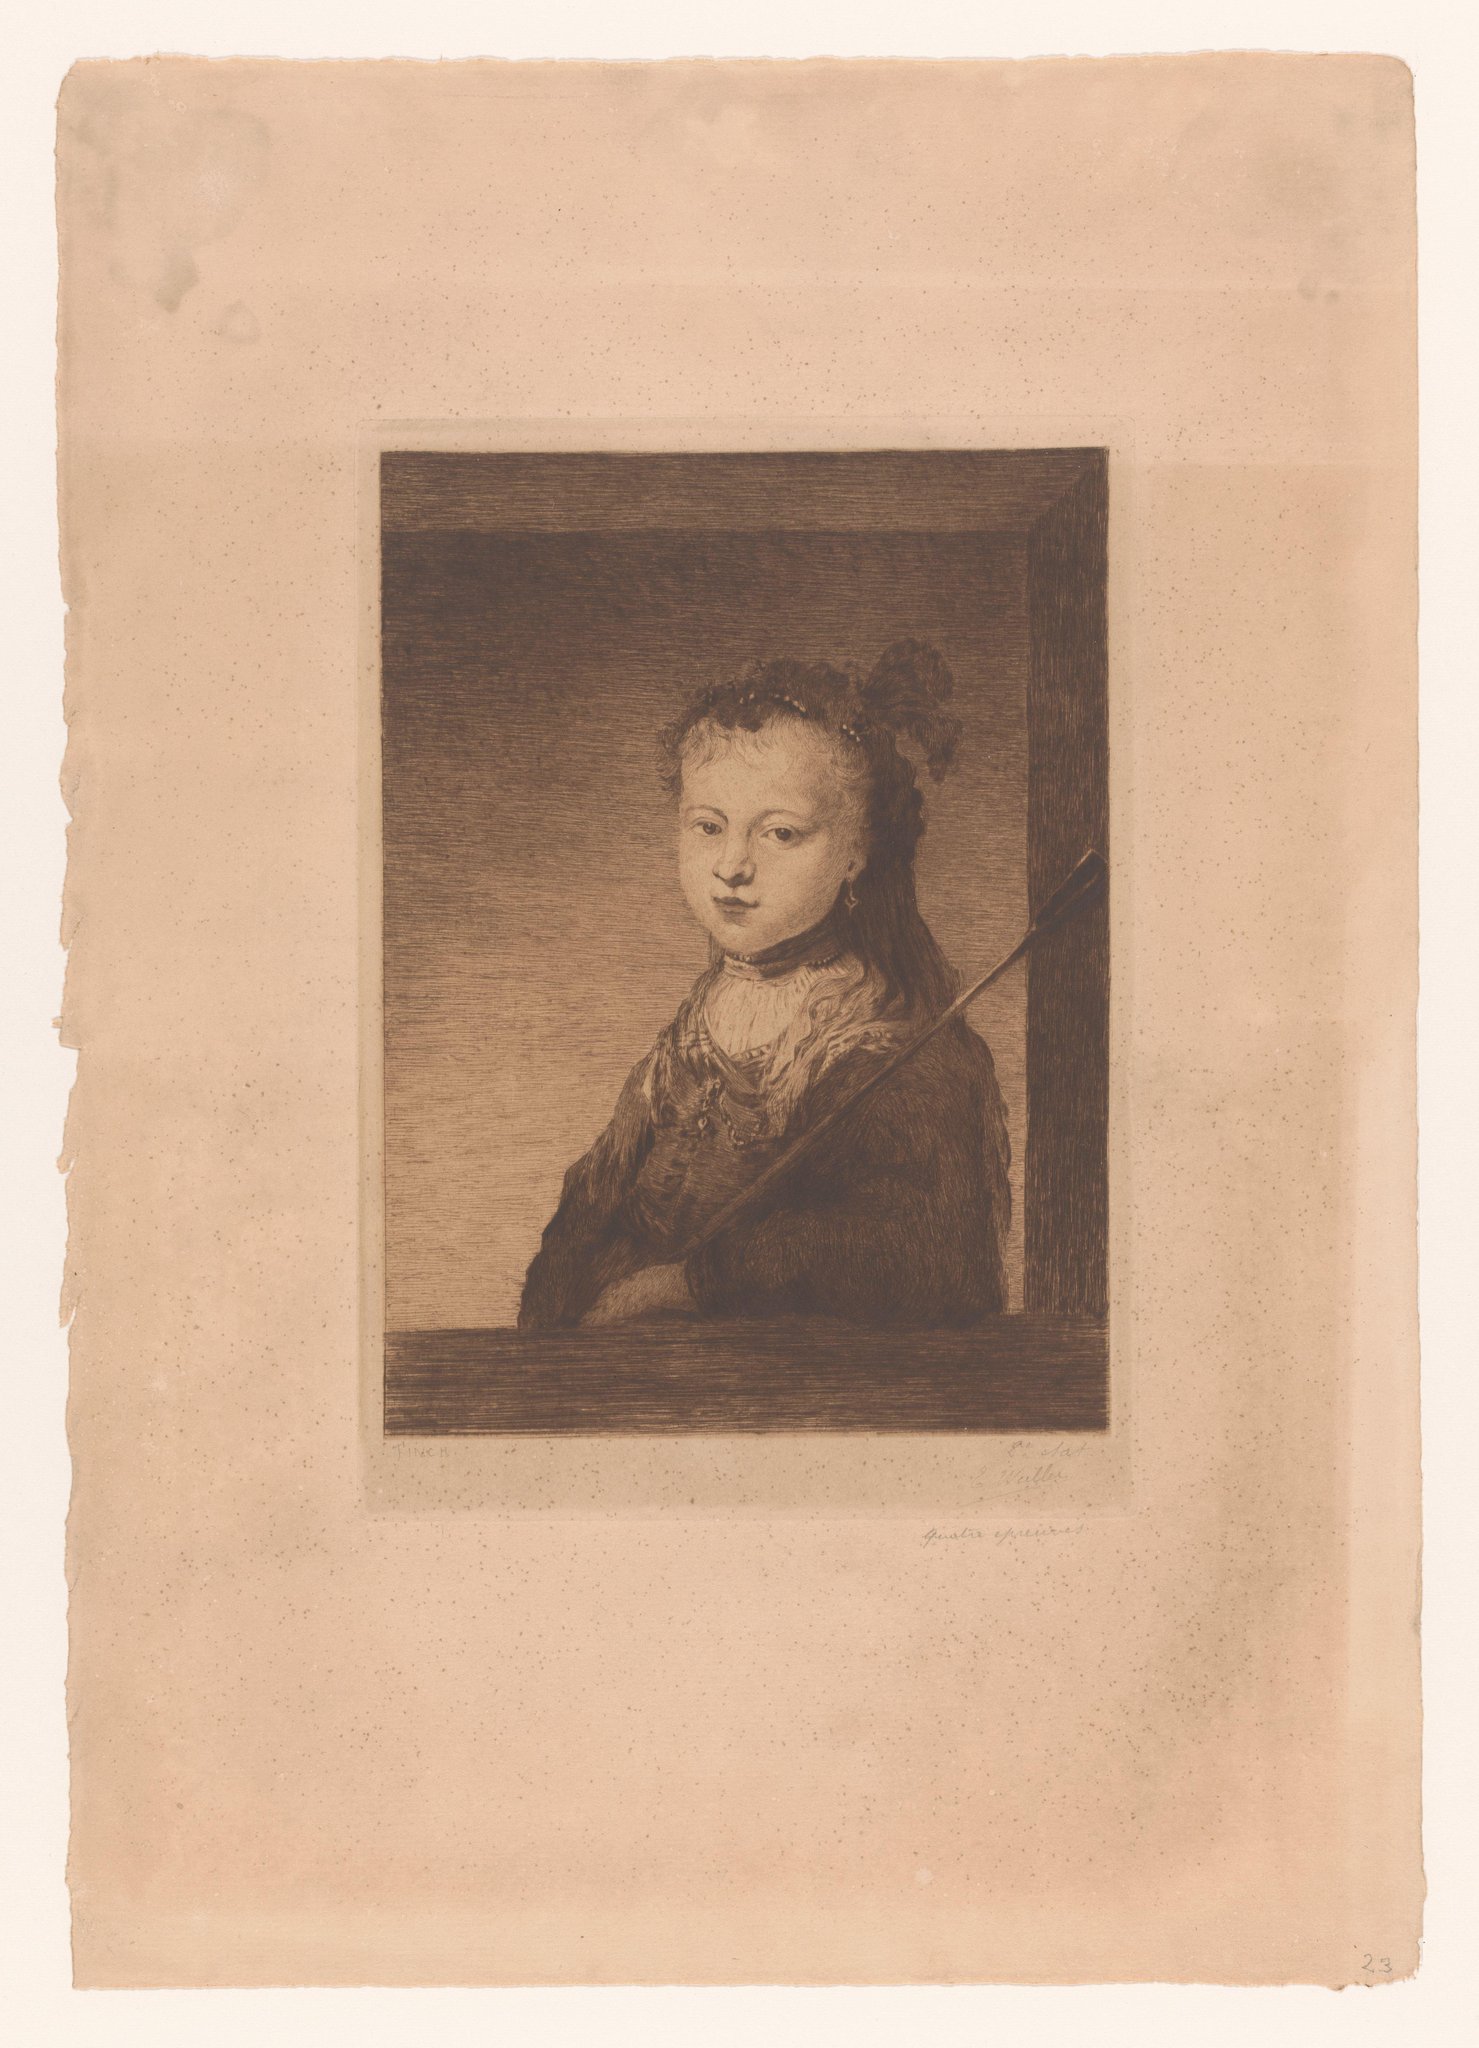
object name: print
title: Meisje als herderin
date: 1875-1913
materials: paper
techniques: drypoint, etching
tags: herding, herdsman, herdswoman, shepherd, shepherdess, cowherd, etc., girl (child between toddler and youth)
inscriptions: inscription: ‘2e etat; quatre epreuves’, collector's mark: Lugt 2228